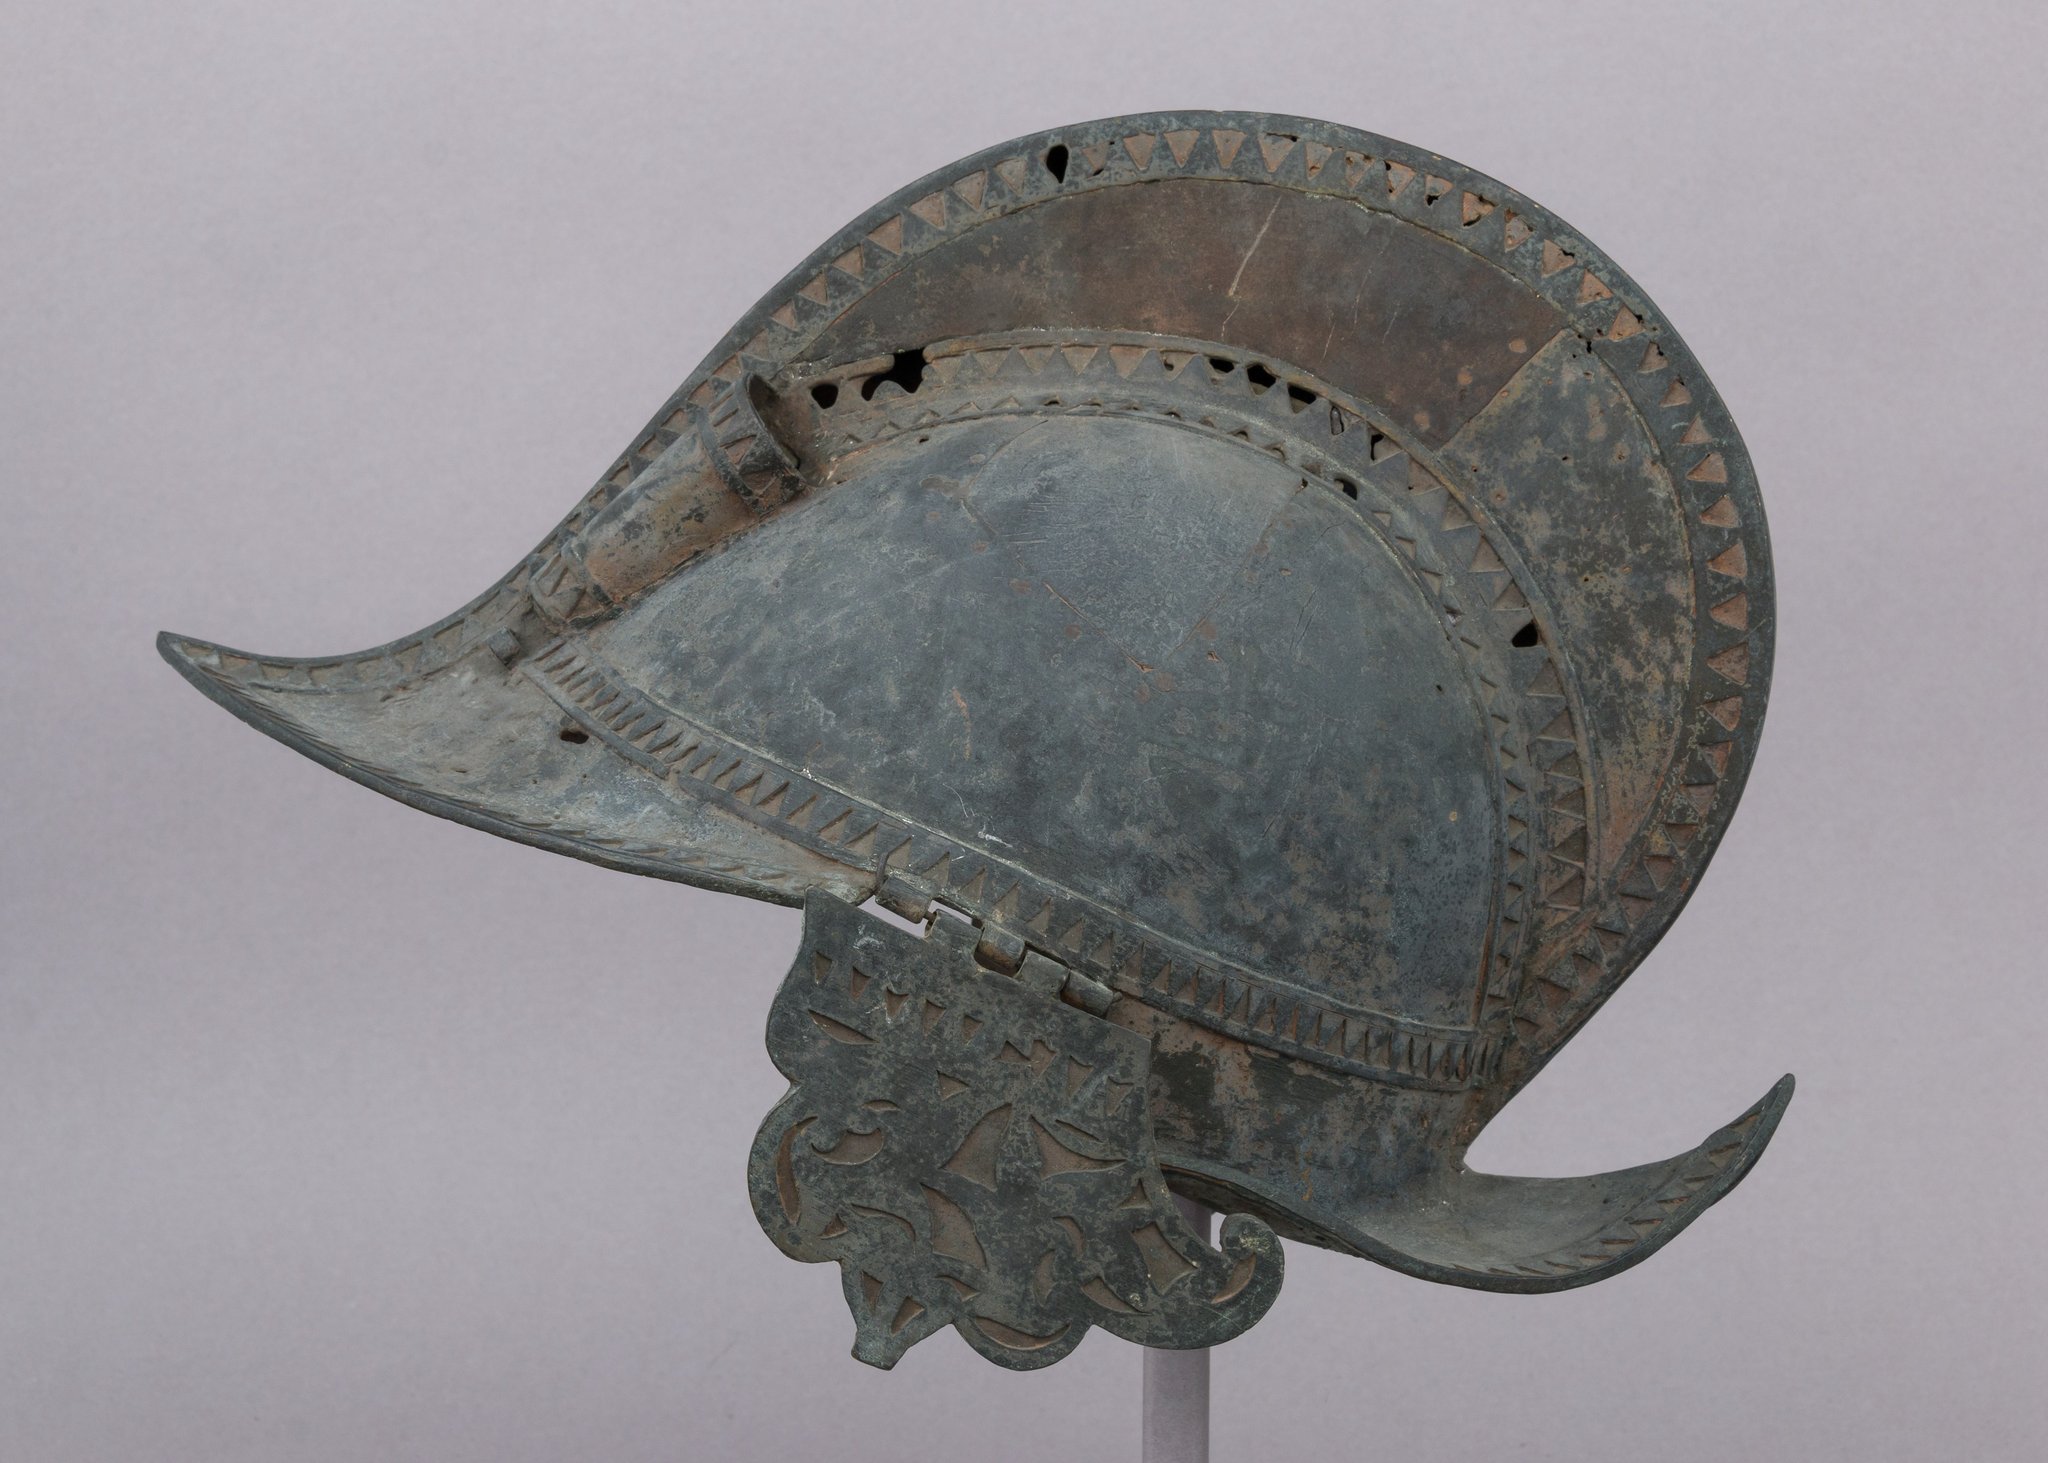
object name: burgonet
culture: philippine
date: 1701-1900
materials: brass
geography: philippines